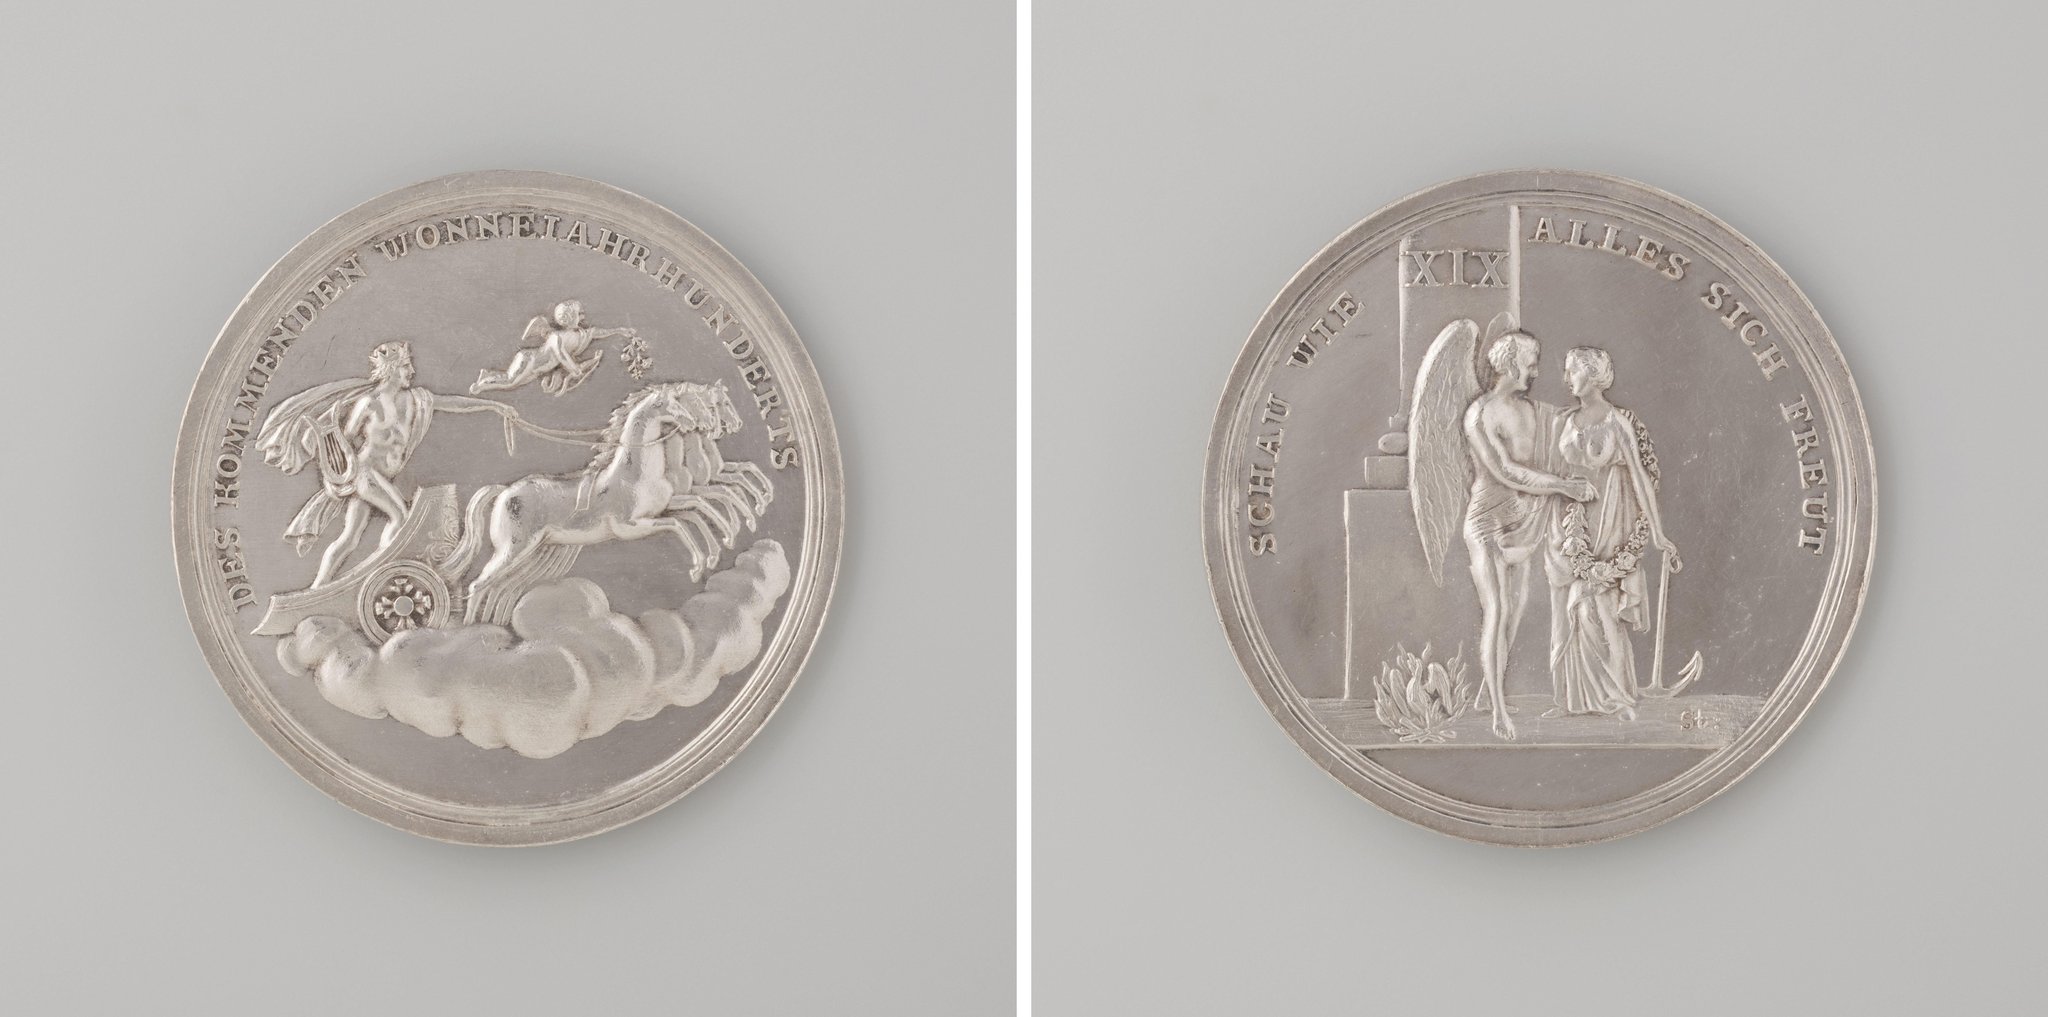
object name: new year medal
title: Aanvang van de 19de eeuw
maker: franz stuckhart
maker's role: medailleur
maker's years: 1781-1857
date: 1799-1800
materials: silver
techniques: striking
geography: prague